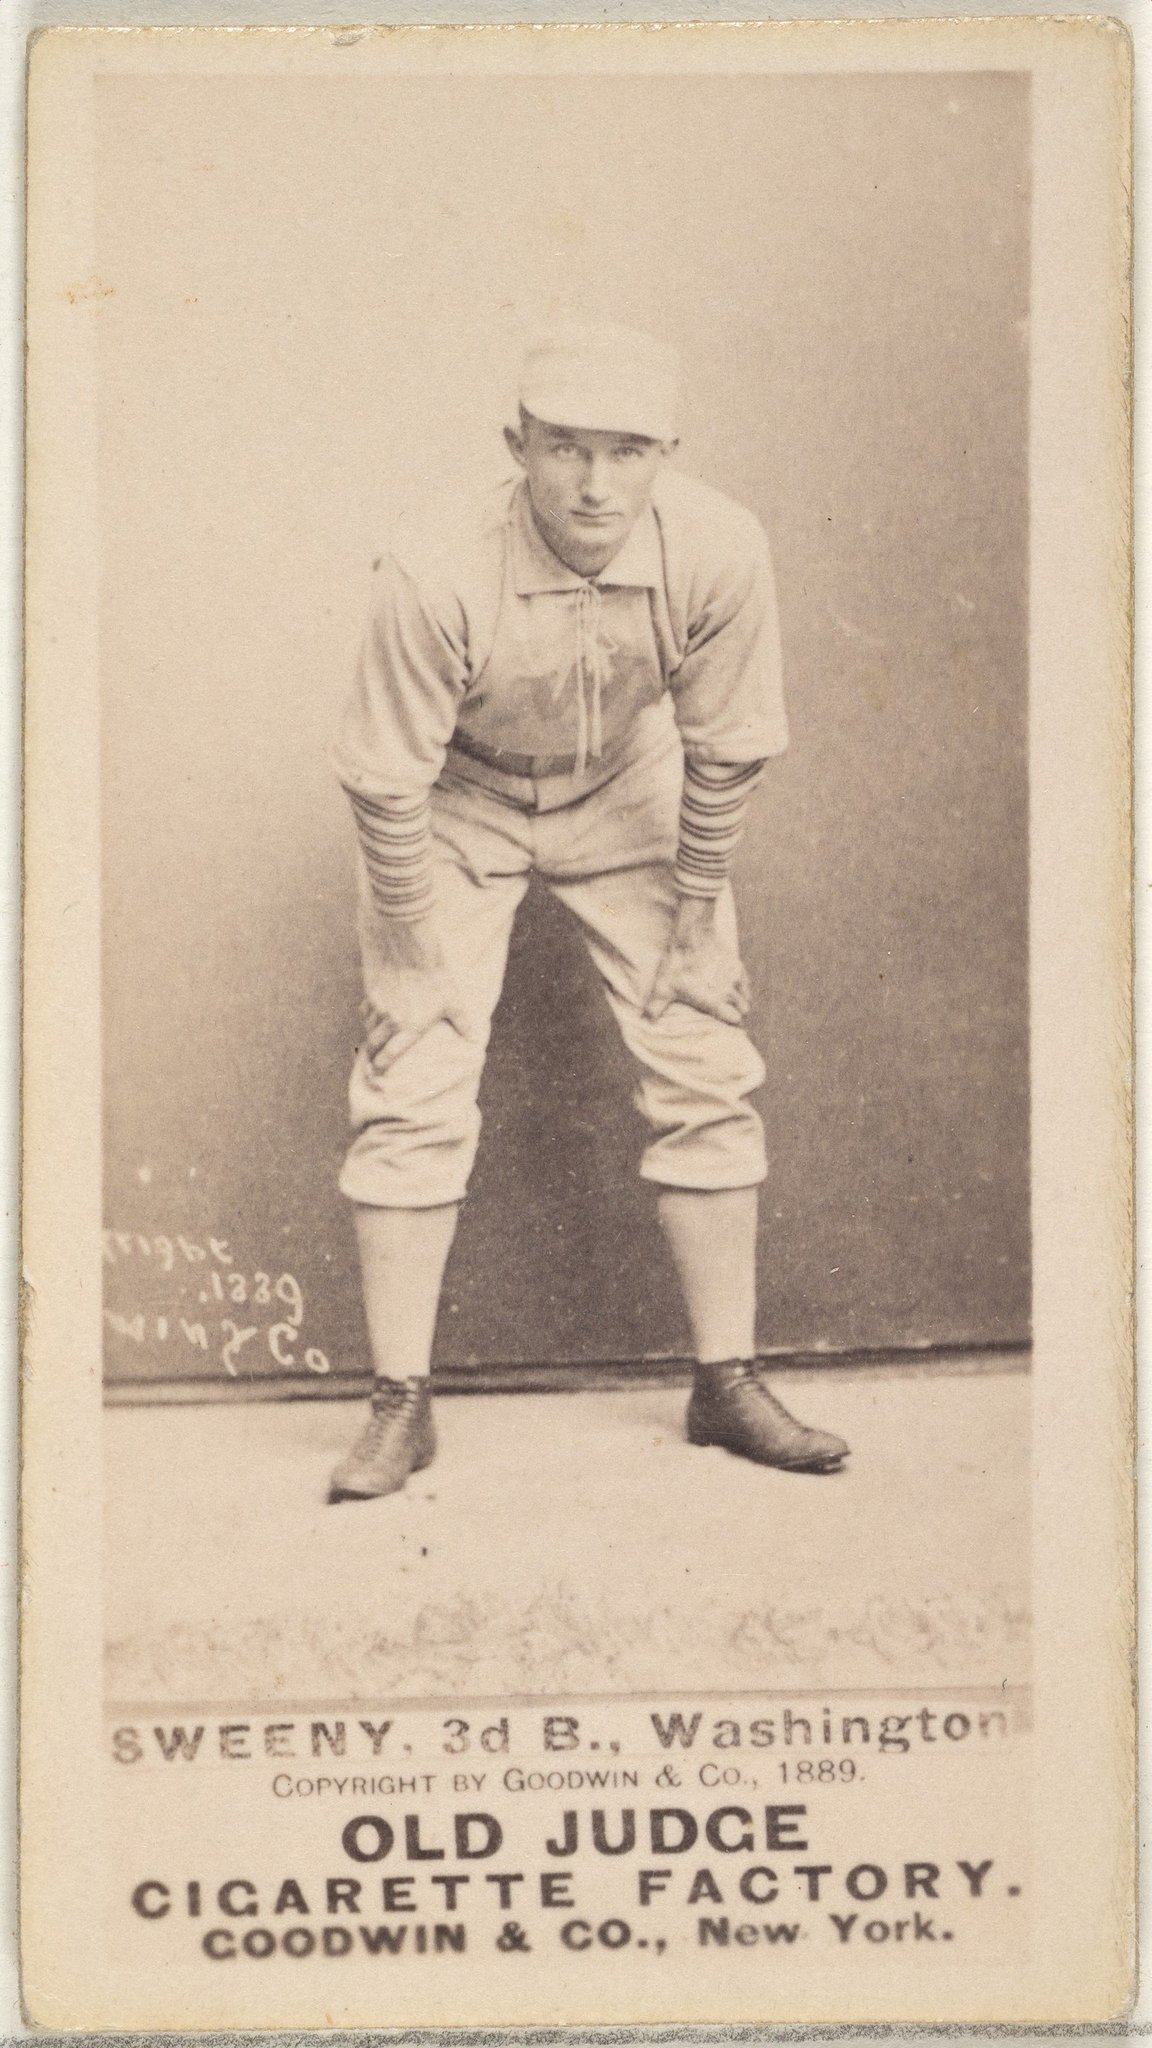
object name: baseball card, photograph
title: Peter Jay "Pete" Sweeney, 3rd Base, Washington Nationals, from the Old Judge series (N172) for Old Judge Cigarettes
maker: goodwin & company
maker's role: publisher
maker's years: 1850-1950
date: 1889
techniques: albumen silver print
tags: men,portraits,baseball,athletes